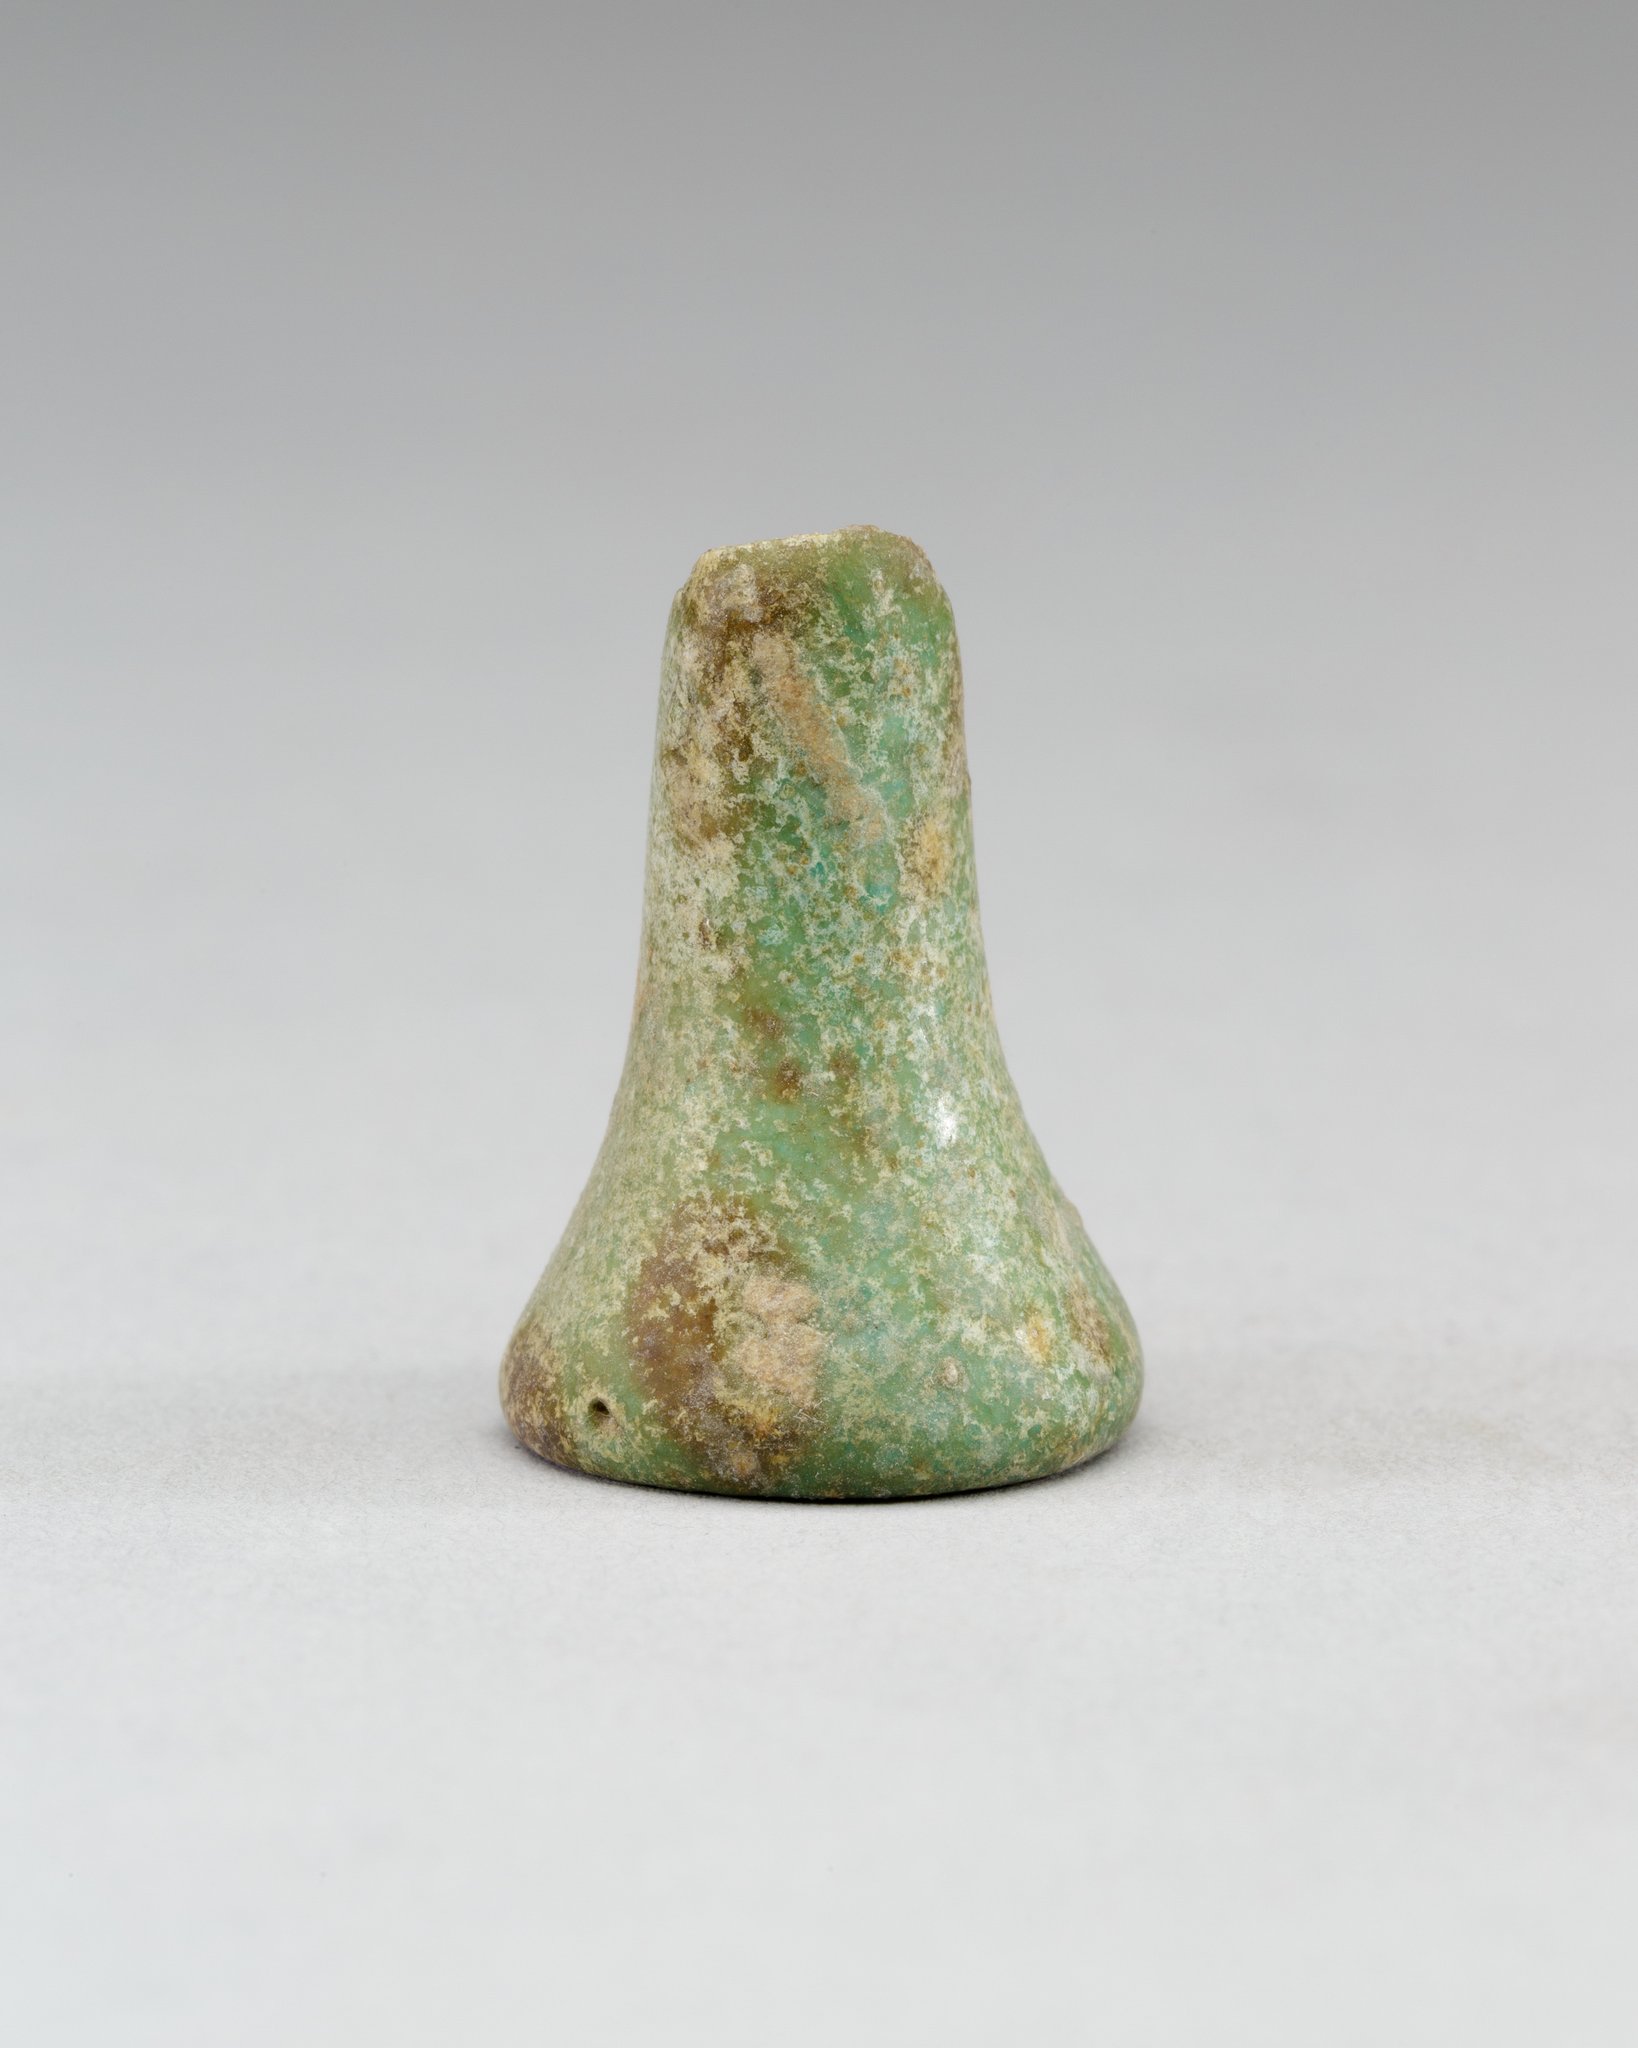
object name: game piece, conical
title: Conical Game Piece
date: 1504-1447 BCE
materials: faience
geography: egypt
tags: games